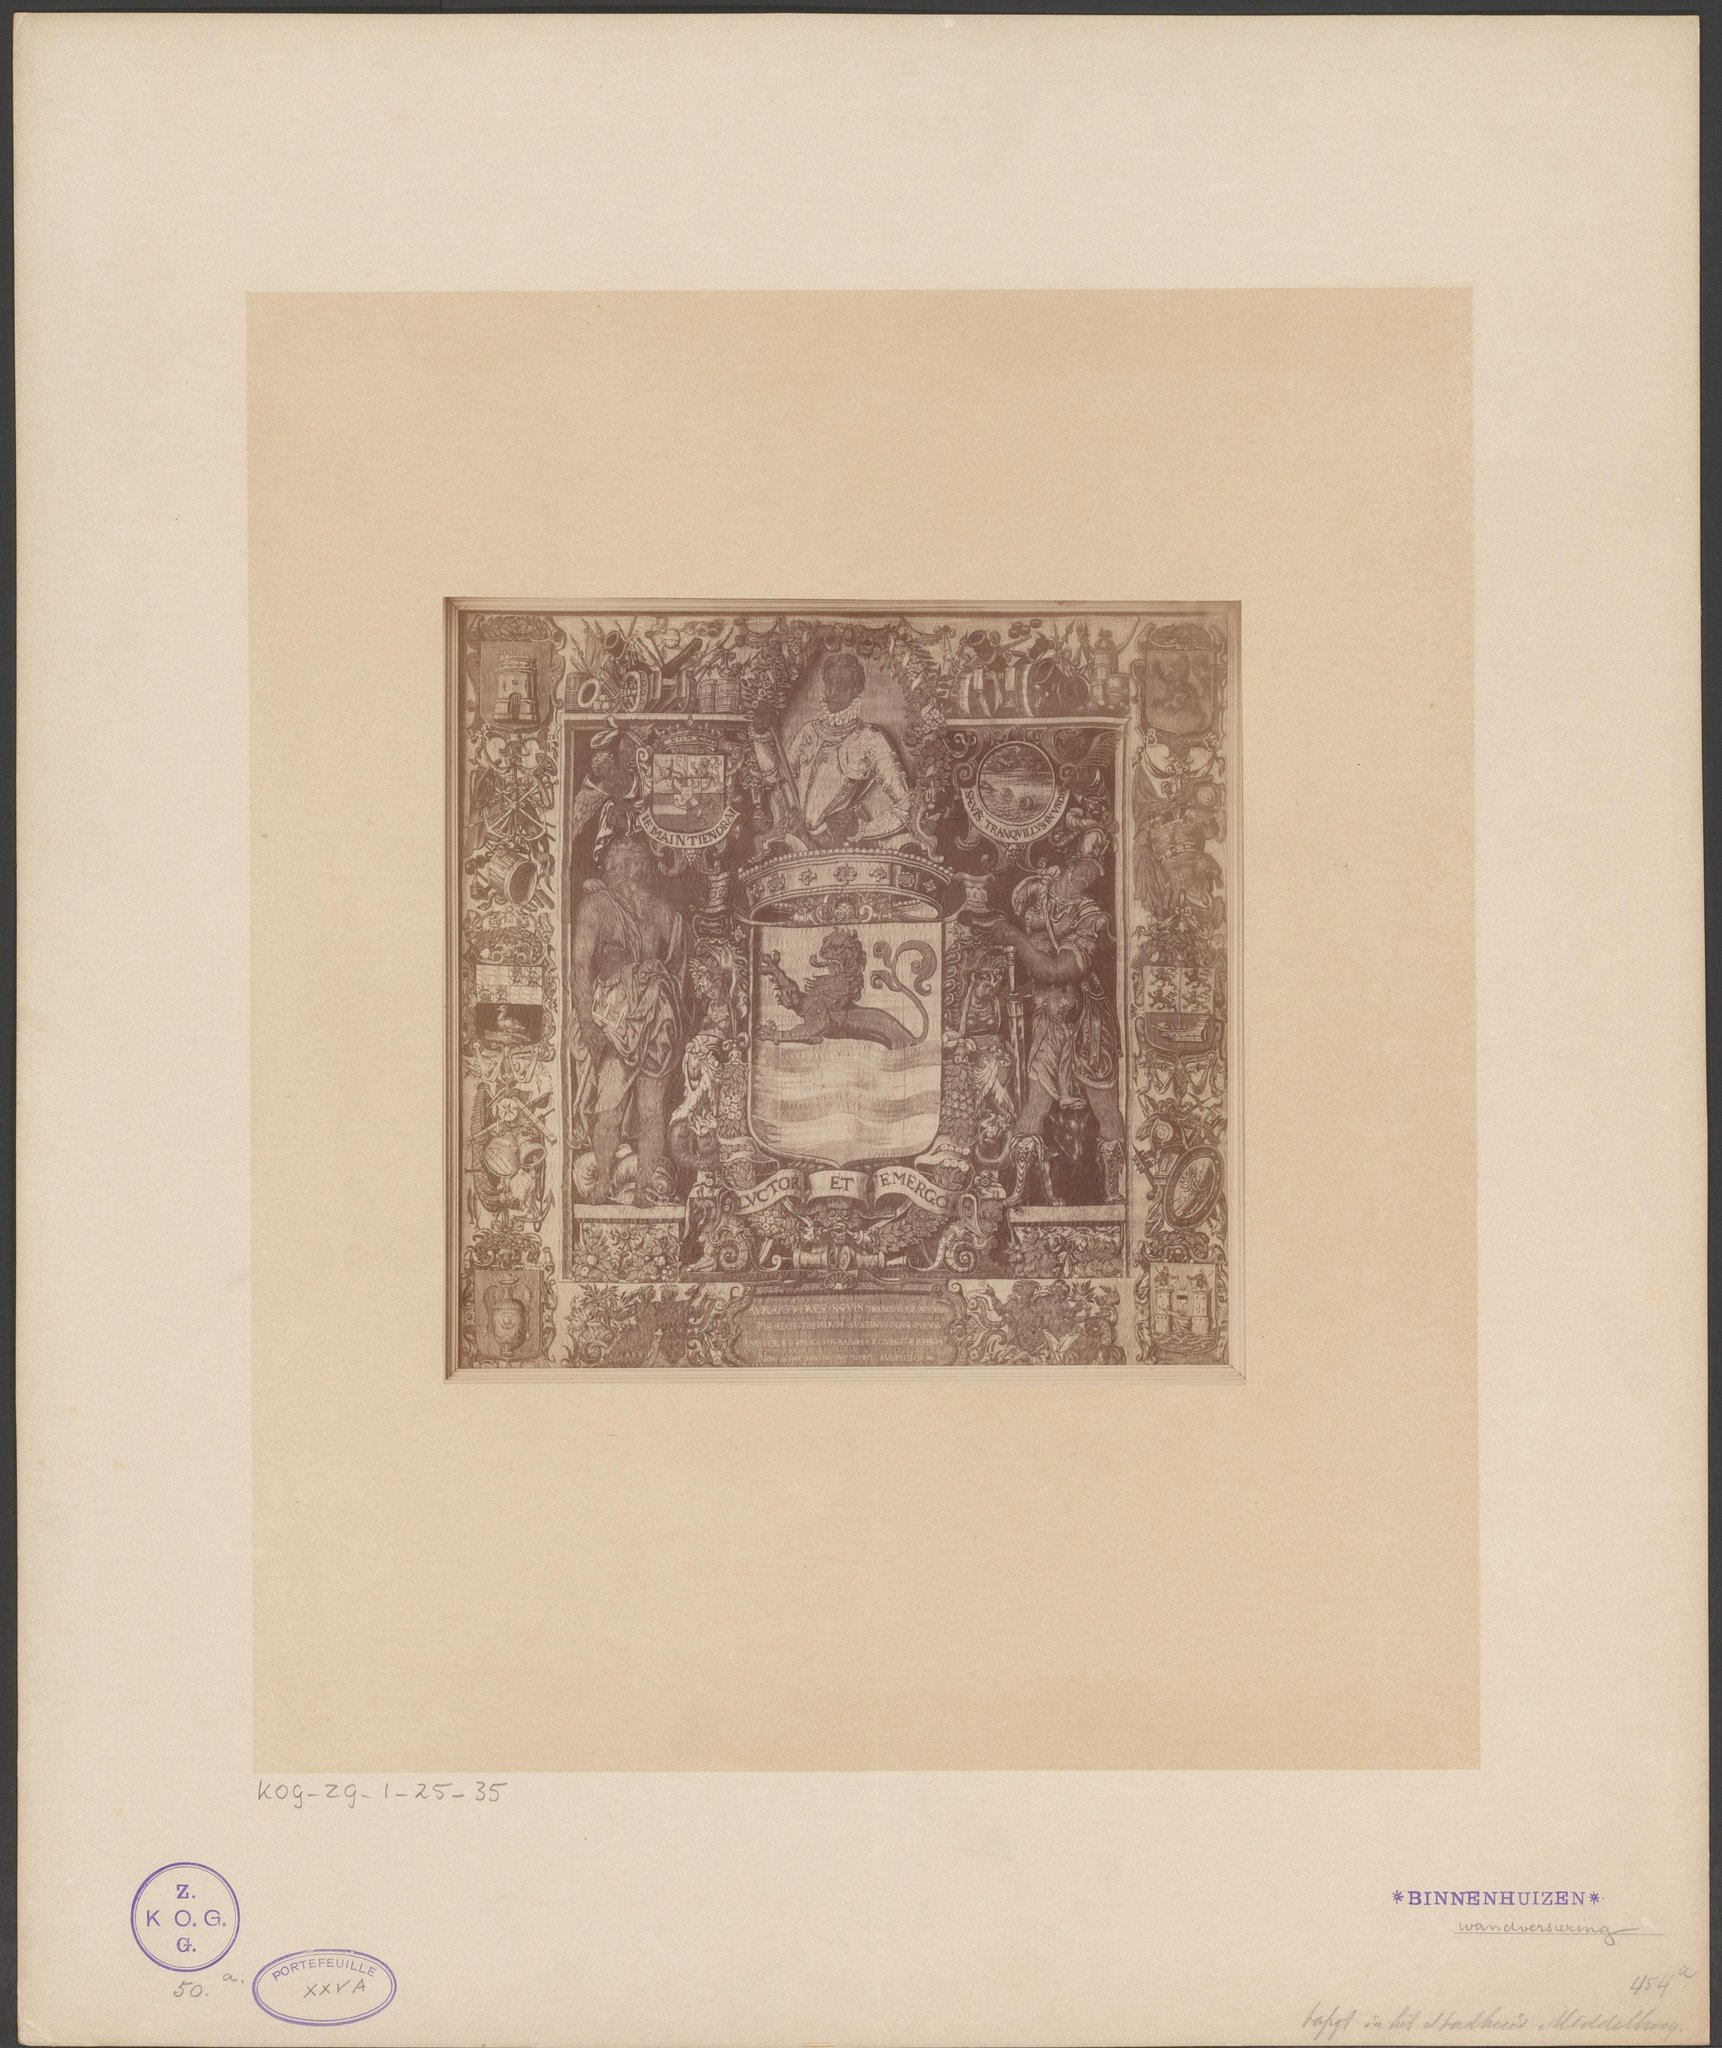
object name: photograph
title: Wandtapijt met het wapen van Zeeland en Willem I, prins van Oranje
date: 1860-1900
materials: paper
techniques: albumen print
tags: delft, william i (prince of orange), tapestry, armorial bearing, heraldry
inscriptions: collector's mark: Lugt 1641, stamp, stamp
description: Wandtapijt uit het stadhuis van Middelburg. Onderwerpsrubrieken binnen de Atlas Zeden en Gewoonten: Zeden en Gewoonten in Engeren Zin, De Woning, Binnenhuizen, Wandversiering.